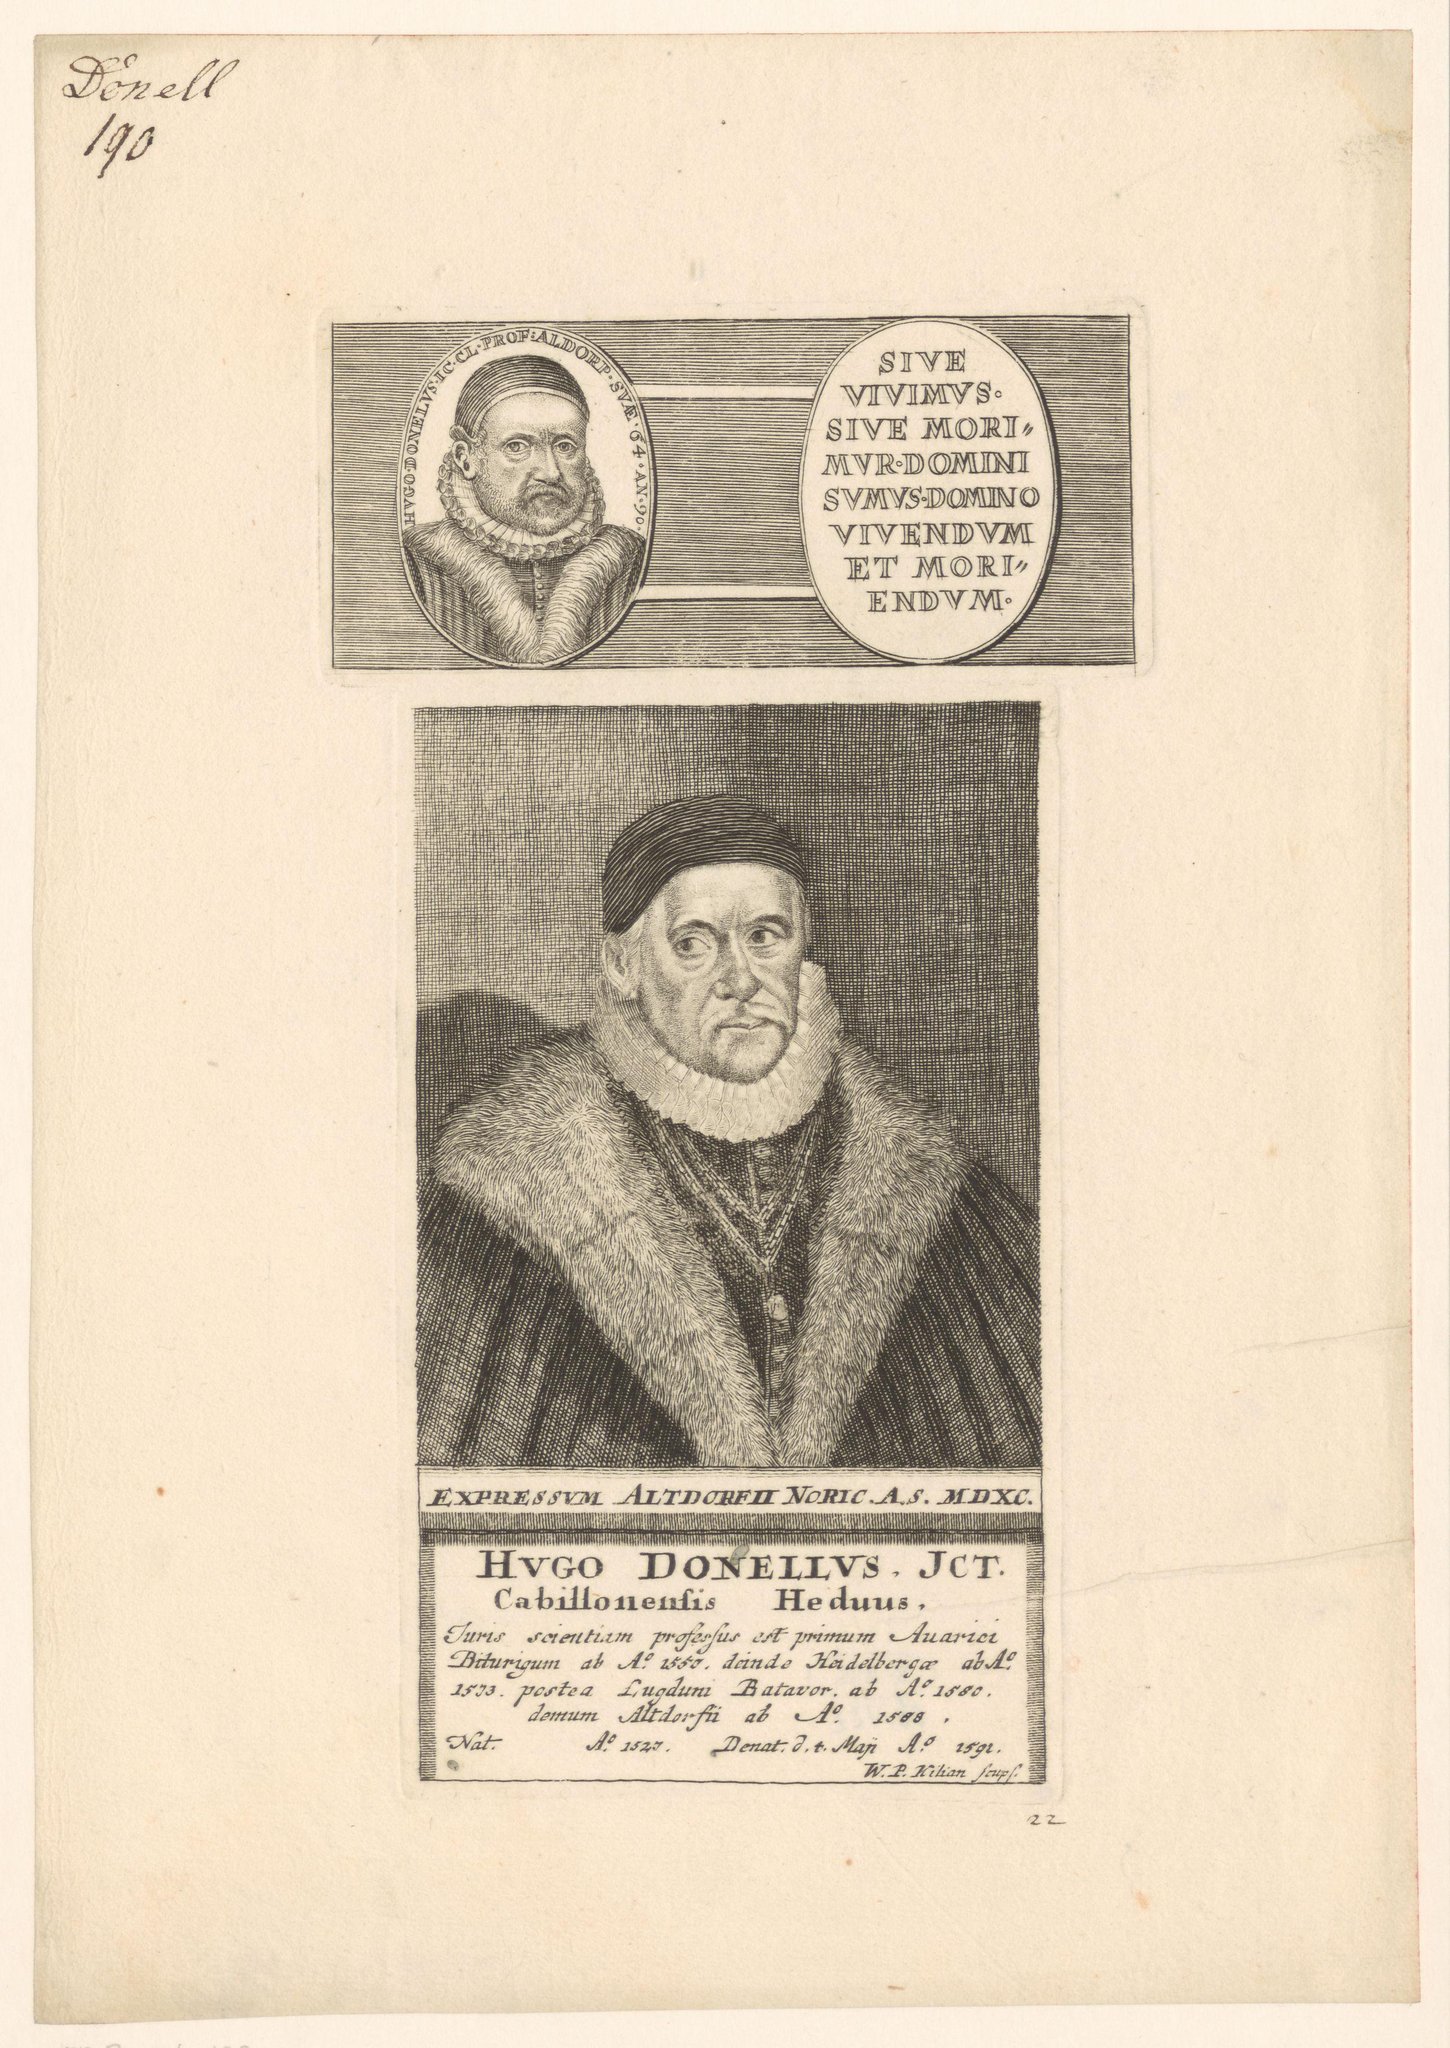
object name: print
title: Twee portretten van Hugo Donellus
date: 1669-1732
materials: paper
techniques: engraving, etching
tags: further education (+ portrait of teacher, professor), historical persons, lawyer, attorney at law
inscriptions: collector's mark: Lugt 2228, annotation: ‘22’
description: In de bovenste druk tekst in Latijn in het medaillon. De onderste druk heeft tekst in het Latijn in de ondermarge.